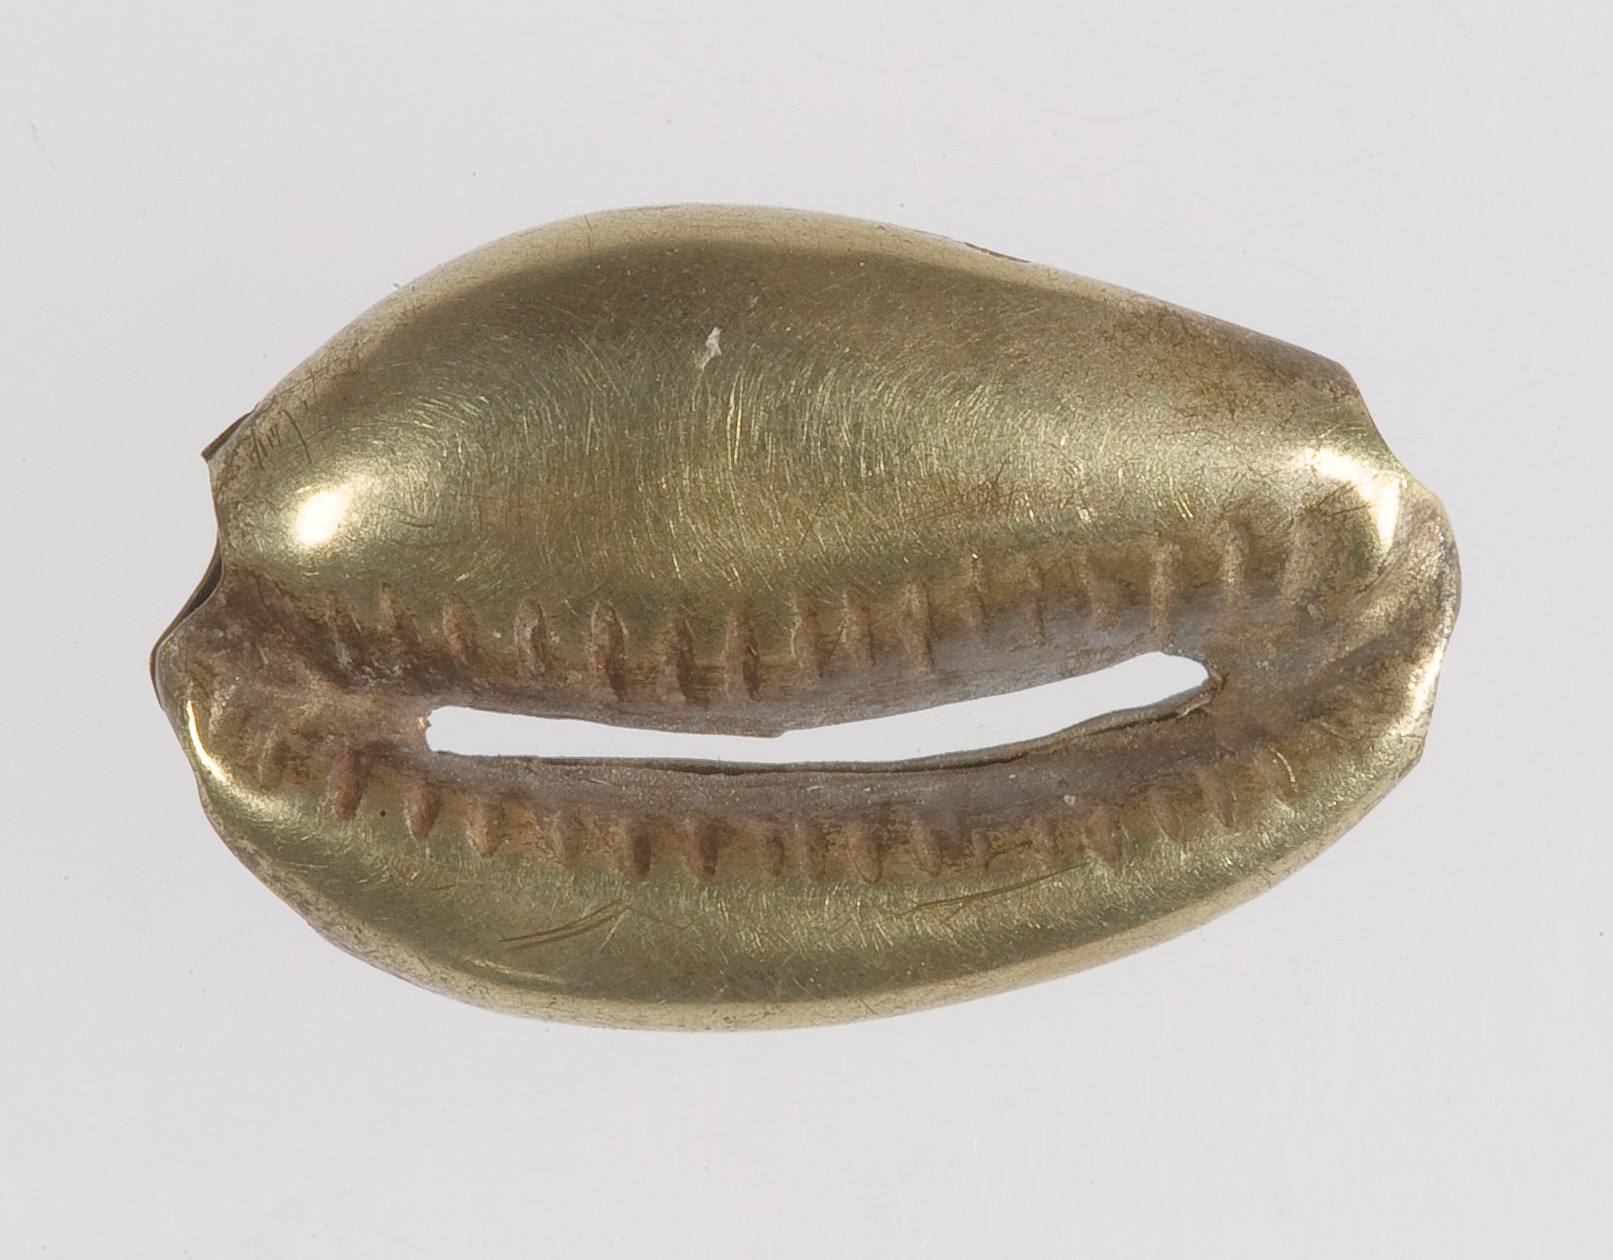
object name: bead, cowrie form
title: Cowrie shell bead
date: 1850-1640 BCE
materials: gold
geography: egypt